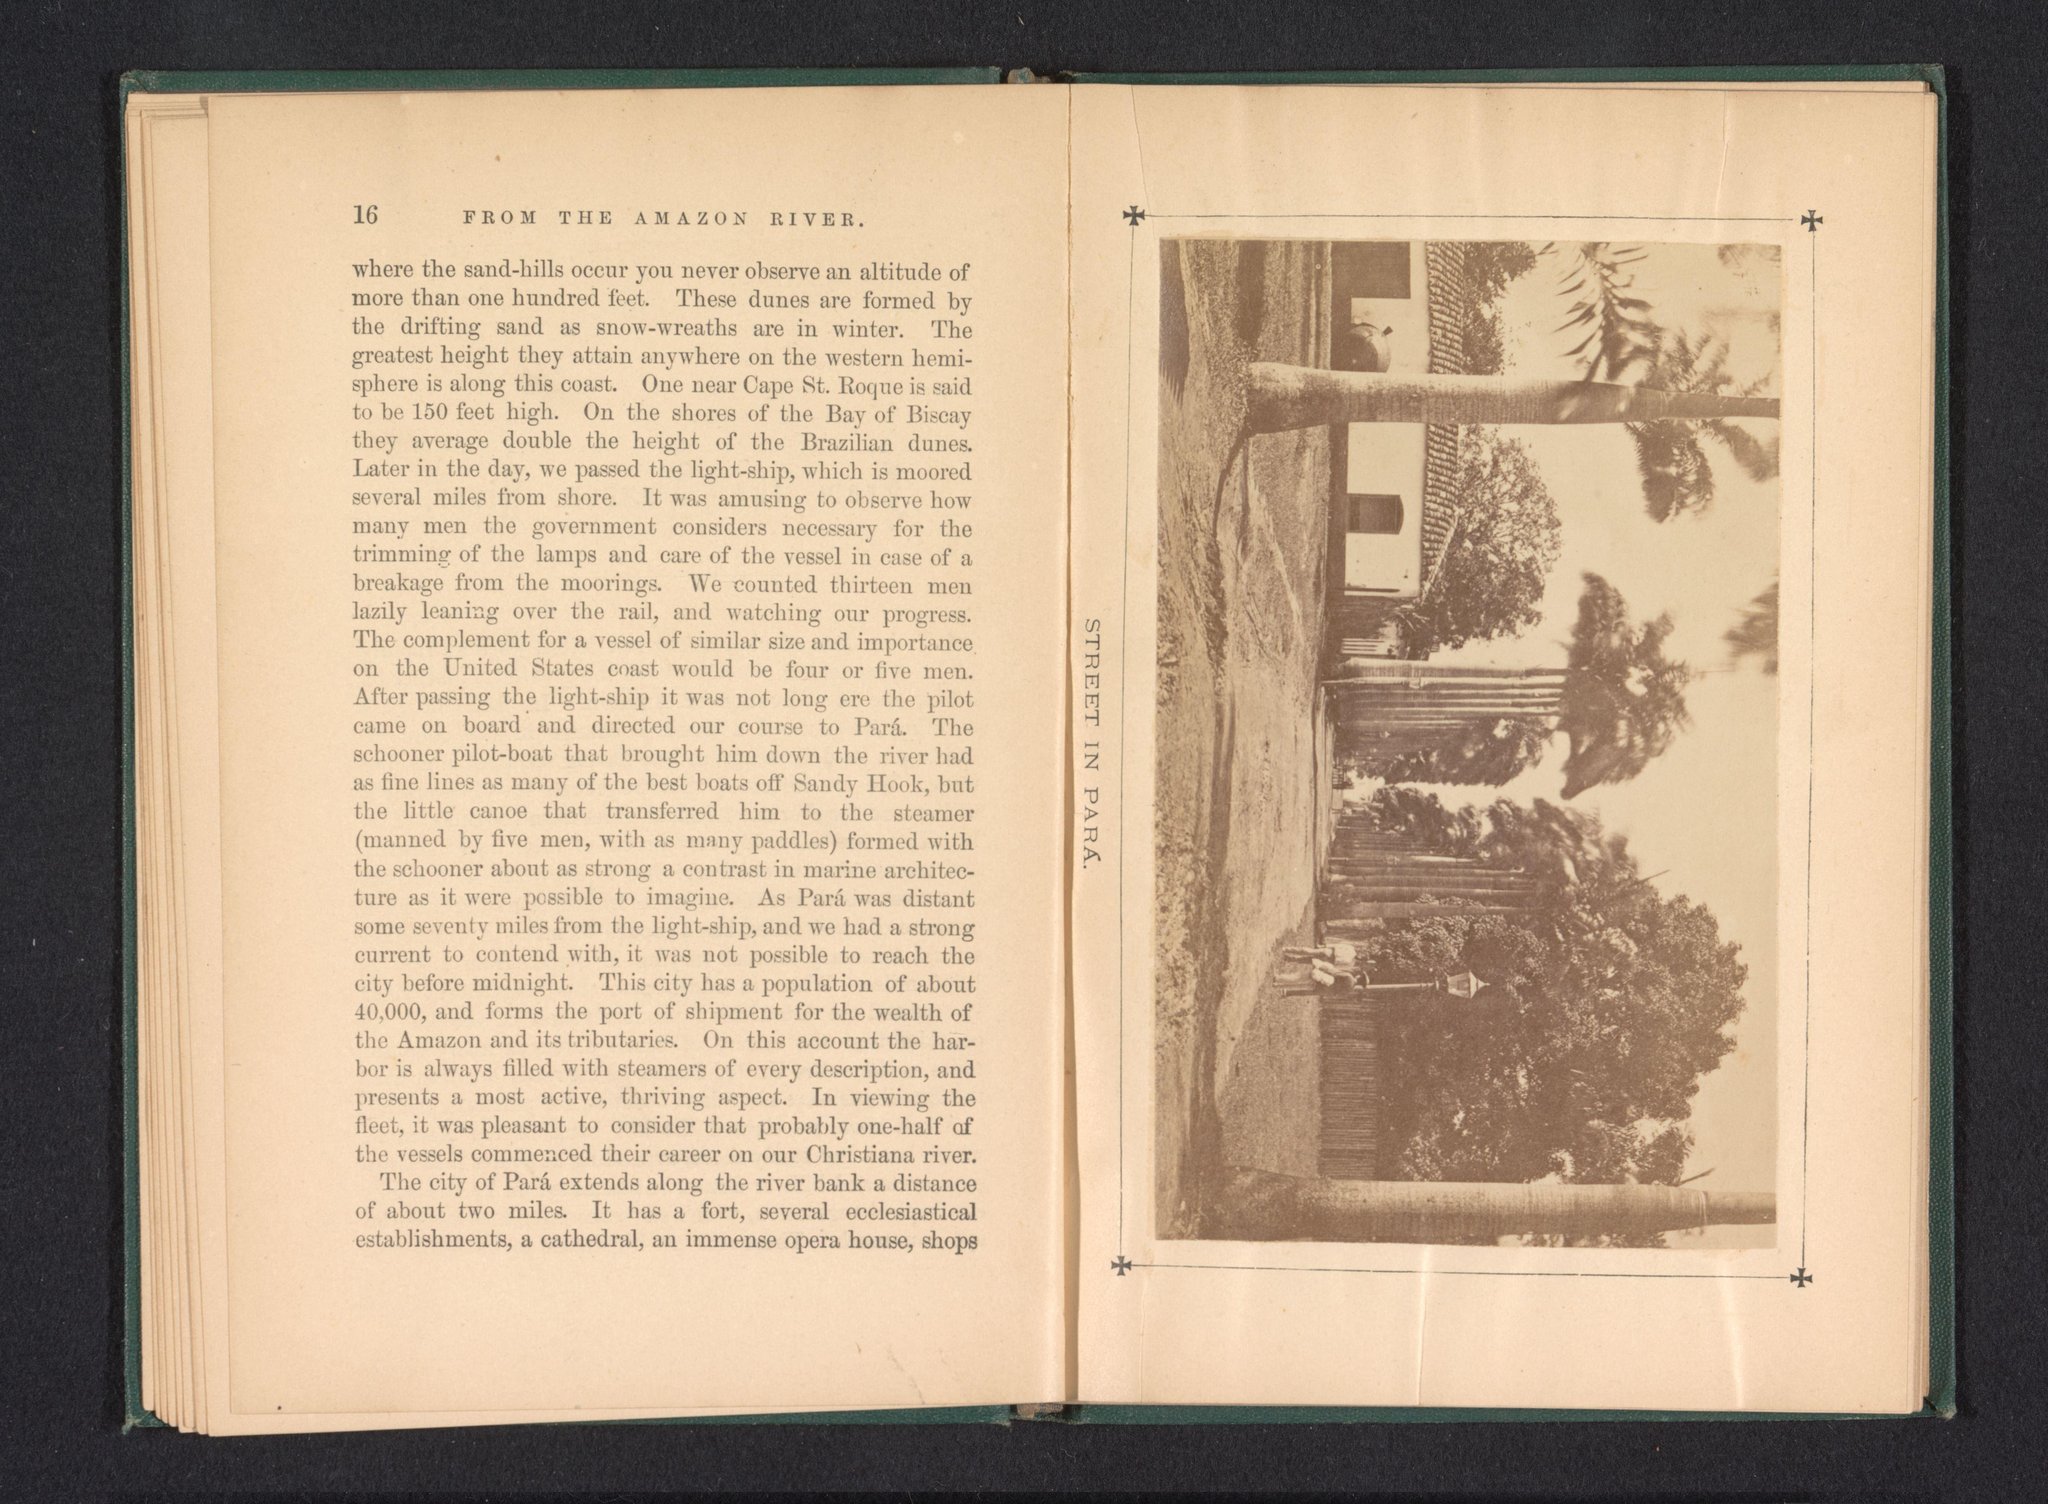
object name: page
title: Gezicht op een weg met palmbomen in de staat Pará in Brazilië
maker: Anonymous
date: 1864-1874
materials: photographic support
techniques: albumen print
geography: pará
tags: trees: palm-tree, street